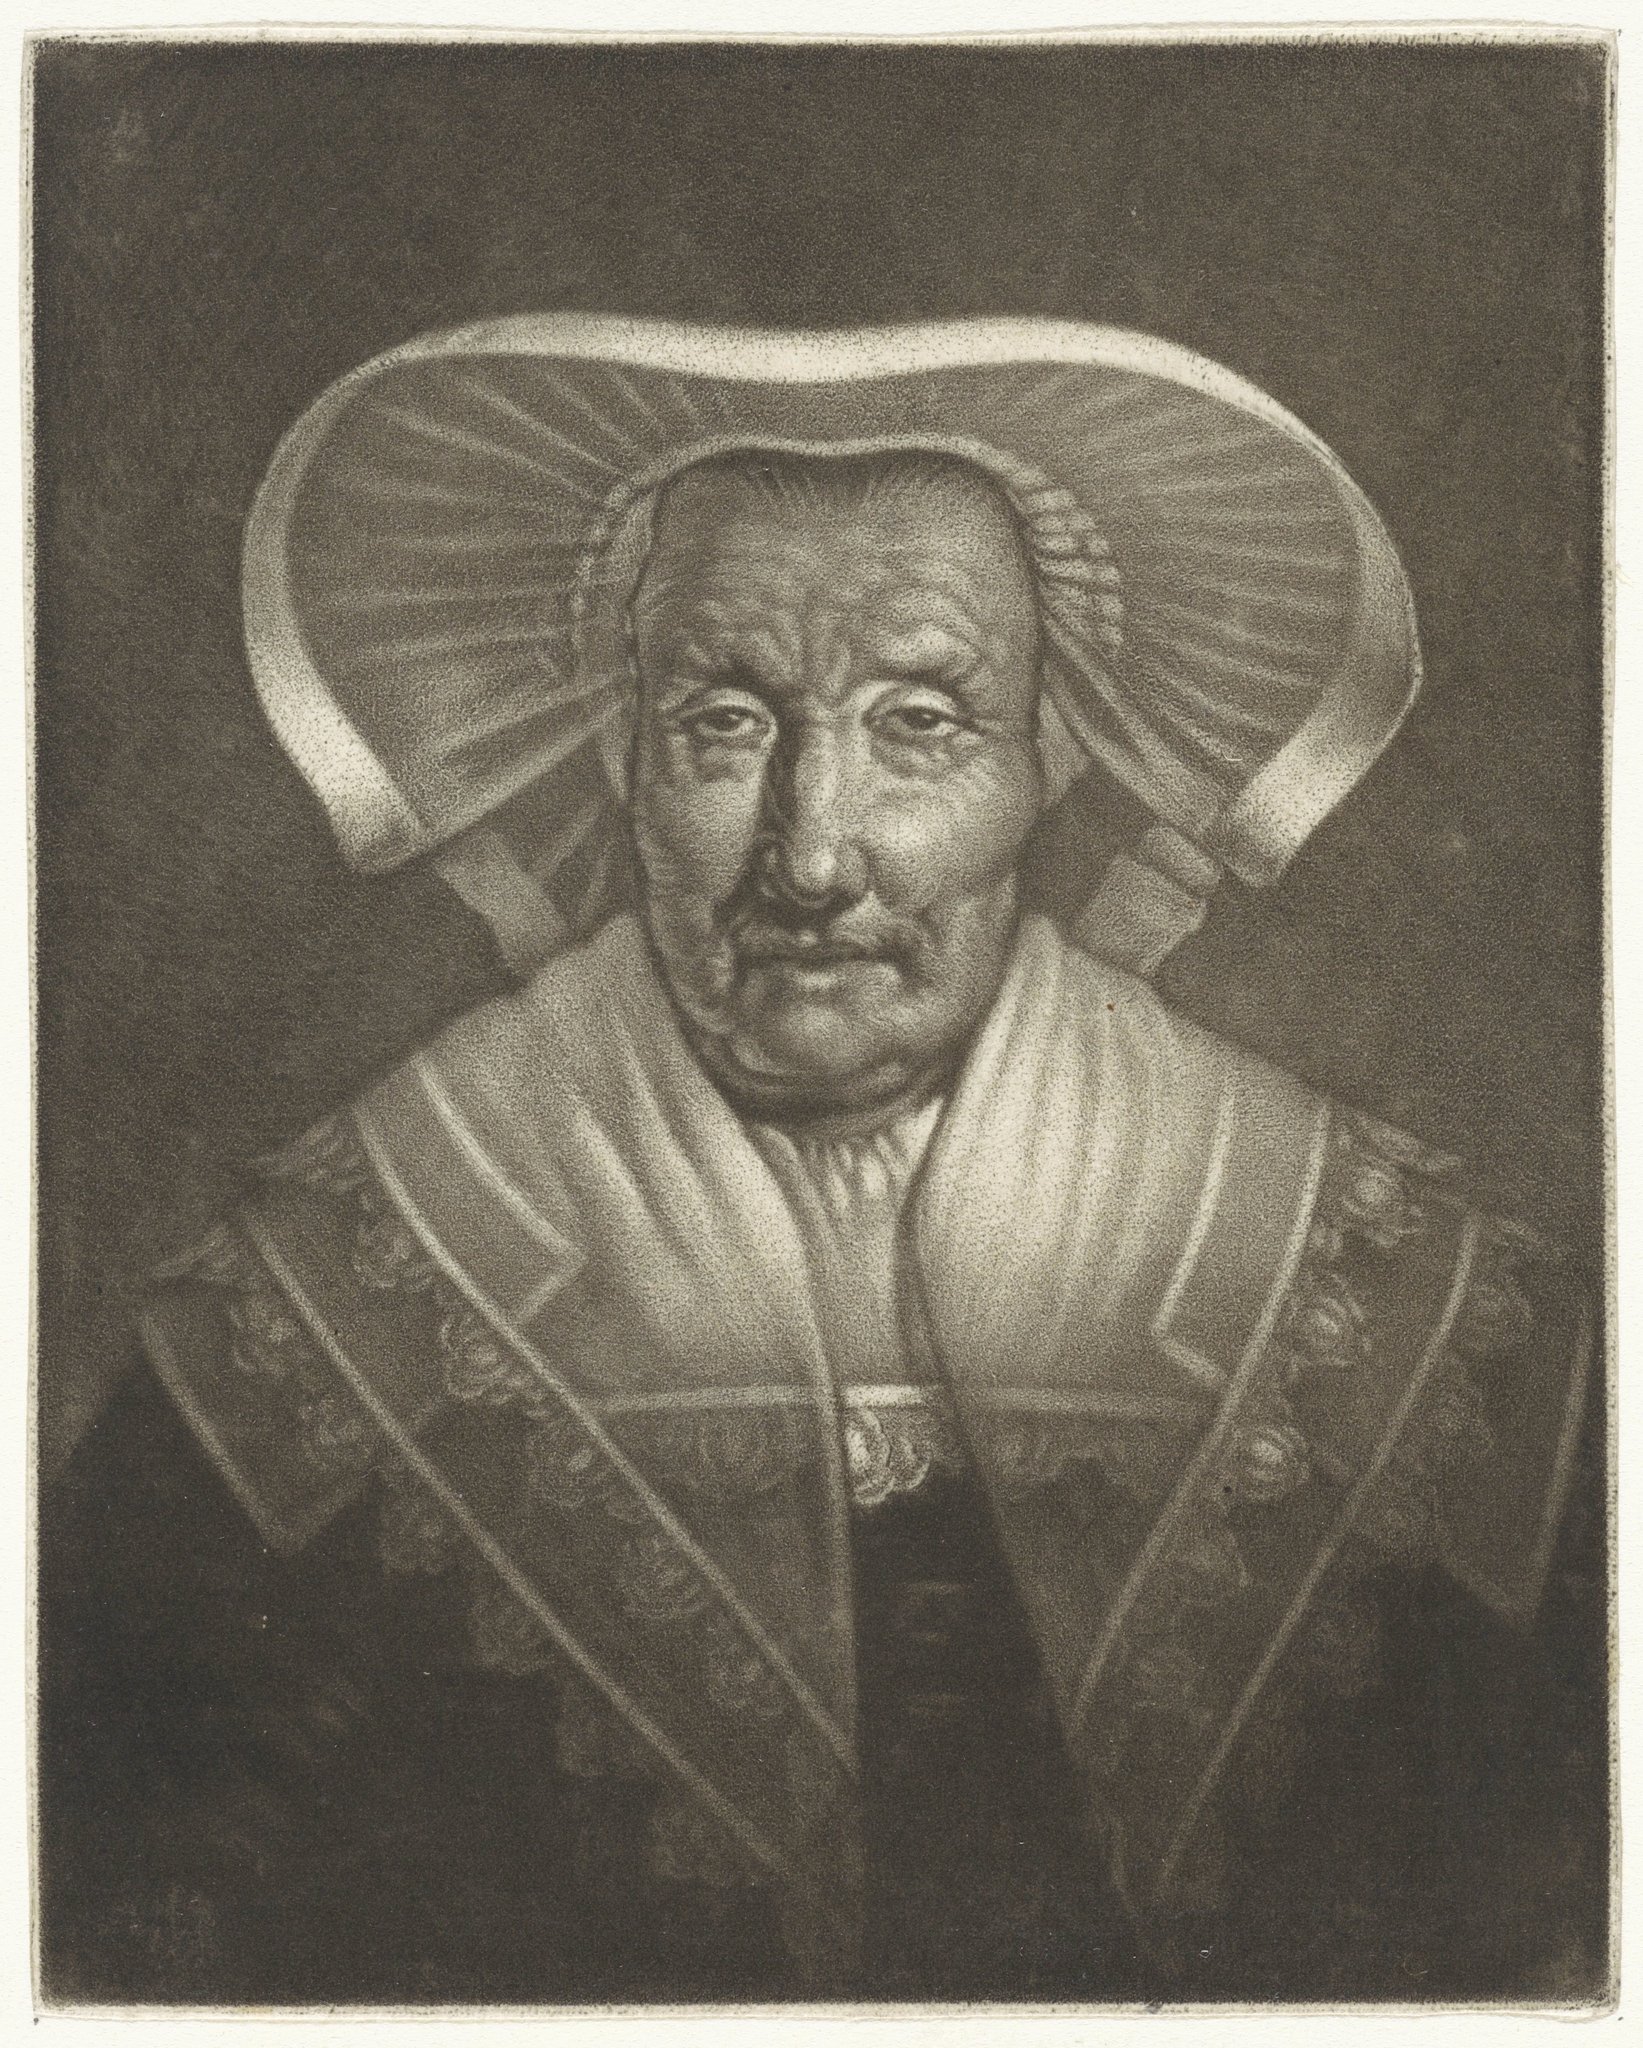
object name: print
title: Portret van een oude vrouw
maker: jan stolker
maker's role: draughtsman, painter, print maker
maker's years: 1724-1785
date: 1734-1785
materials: paper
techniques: mezzotint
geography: northern netherlands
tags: head-gear: cap (+ women's clothes), old woman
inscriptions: collector's mark: Lugt 240